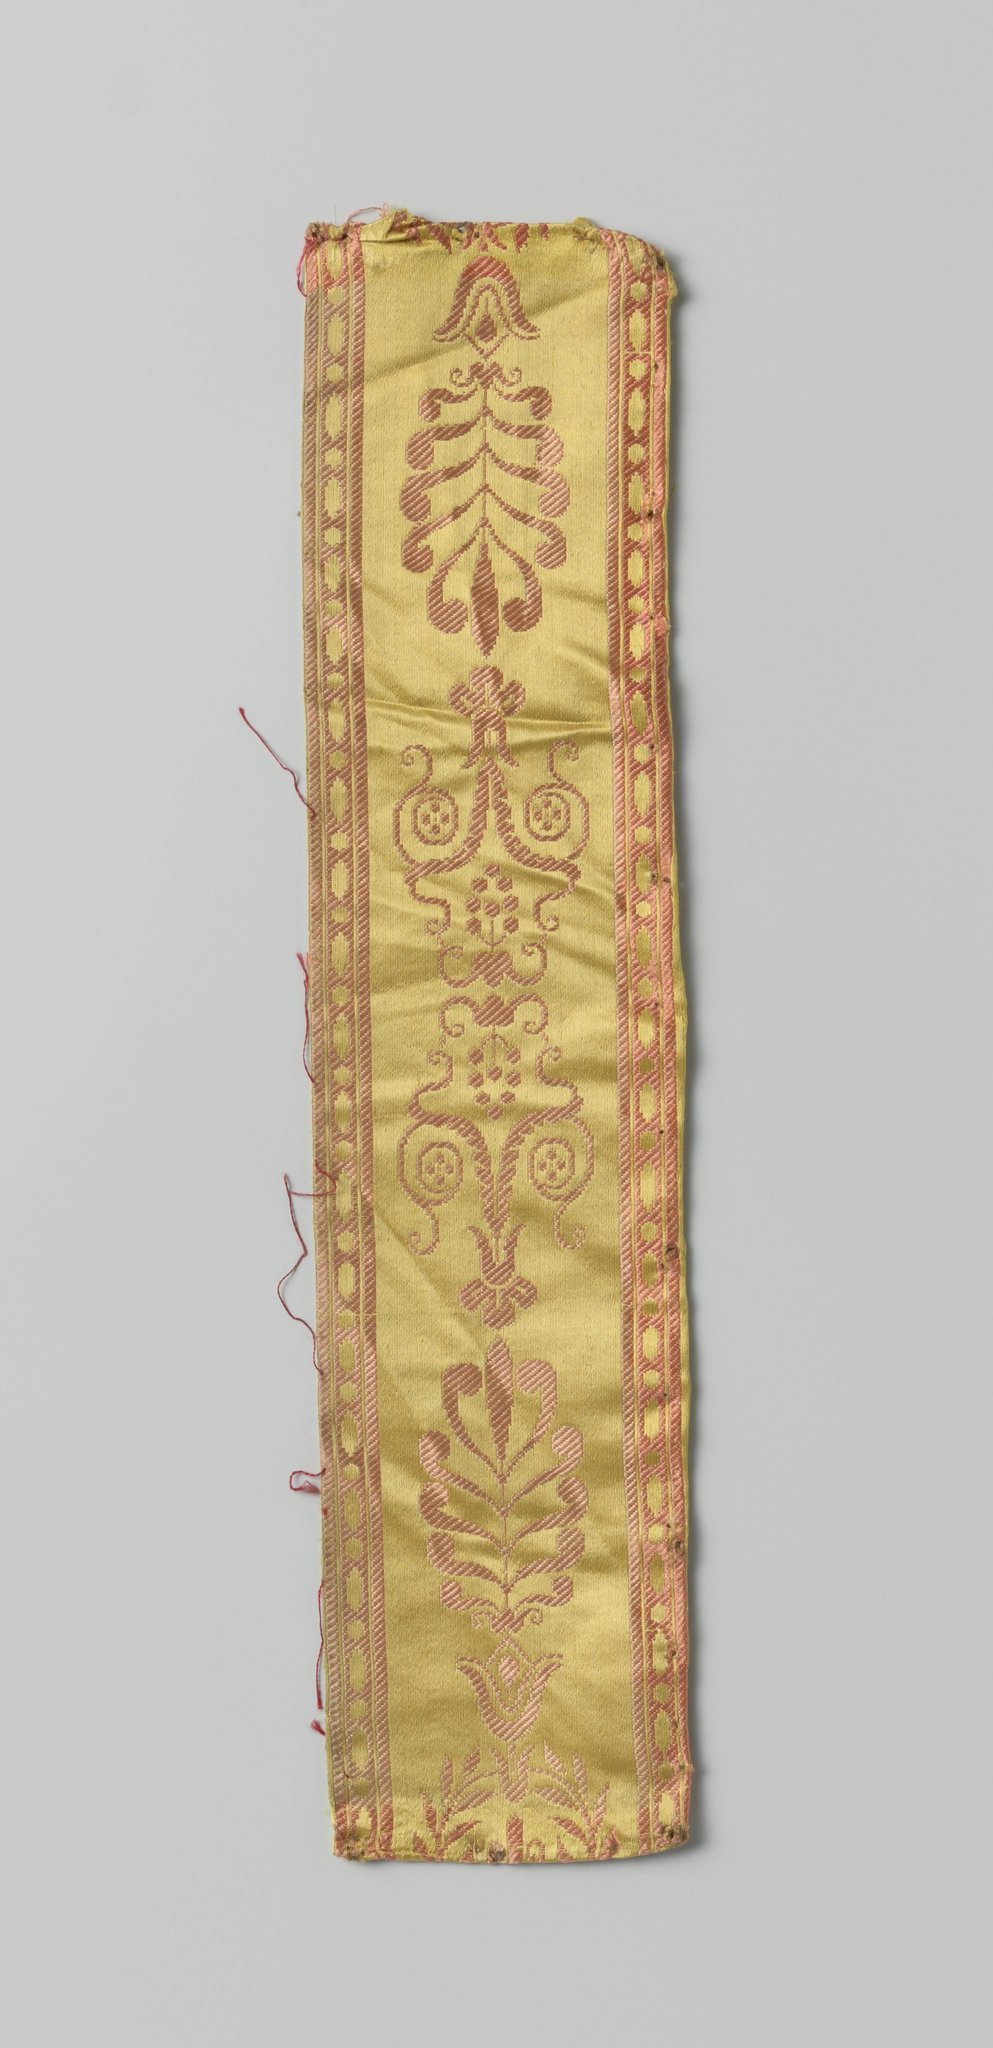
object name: stoelbekleding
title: Fragment zijdeweefsel van een stoelbekleding.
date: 1805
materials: silk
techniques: brocade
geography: france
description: Fragment geel zijdeweefsel, van een stoelbekleding. Het patroon heeft op een gele grond roze palmetten en arabesken. Het fragment hoort bij dertien fragmenten met invnr. BK-1992-18-A t/m BK-1992-18-M.